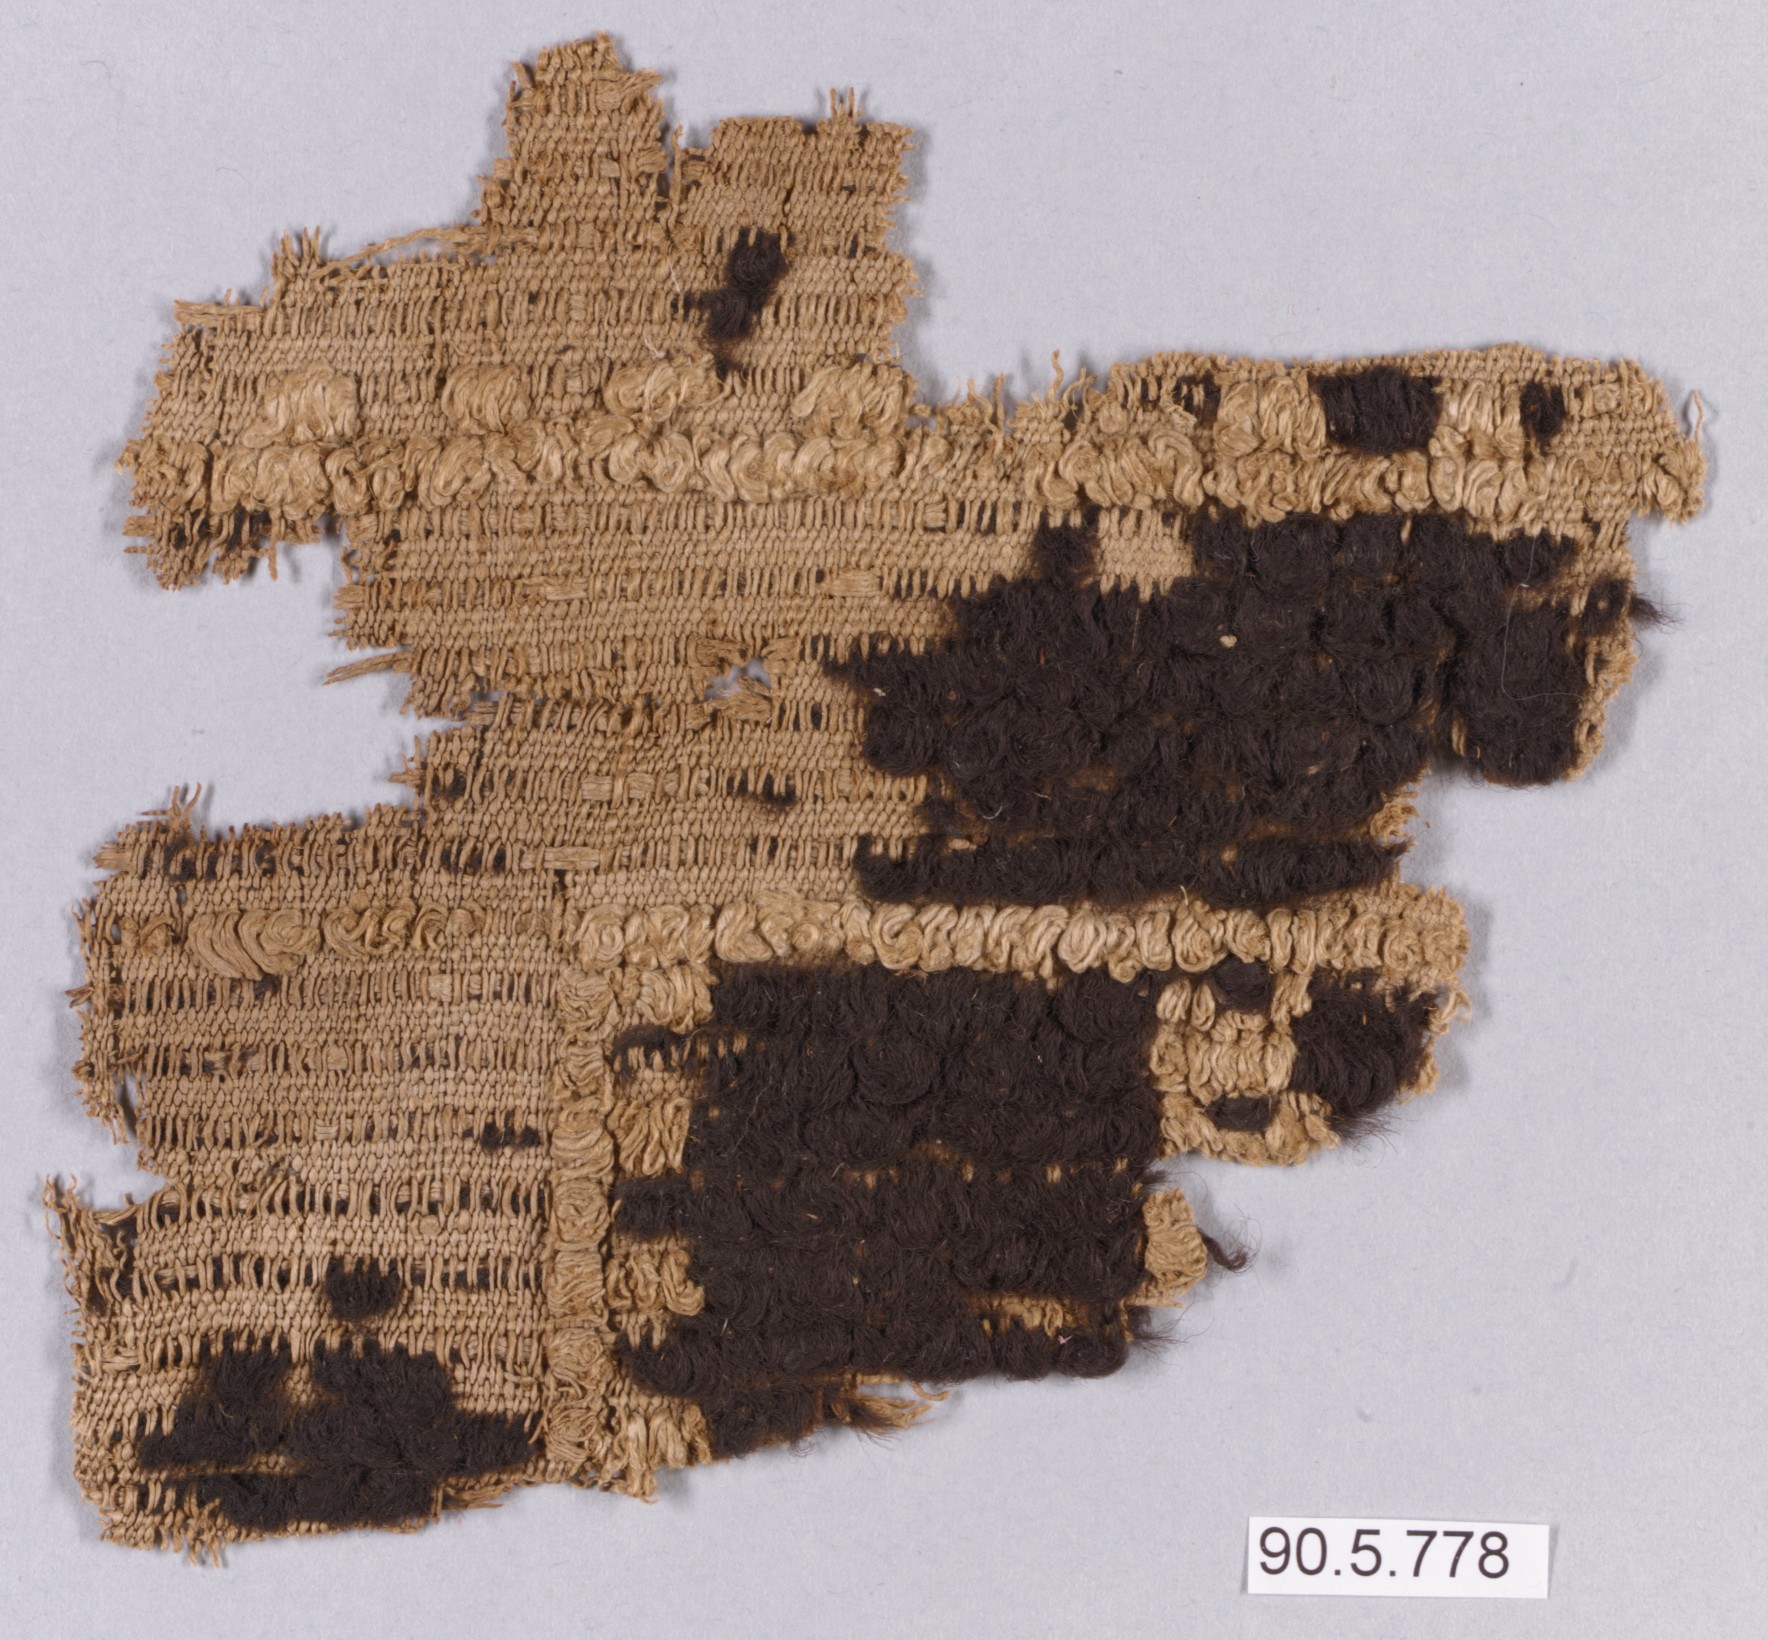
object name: textile fragment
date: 201-400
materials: linen, wool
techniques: weave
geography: egypt